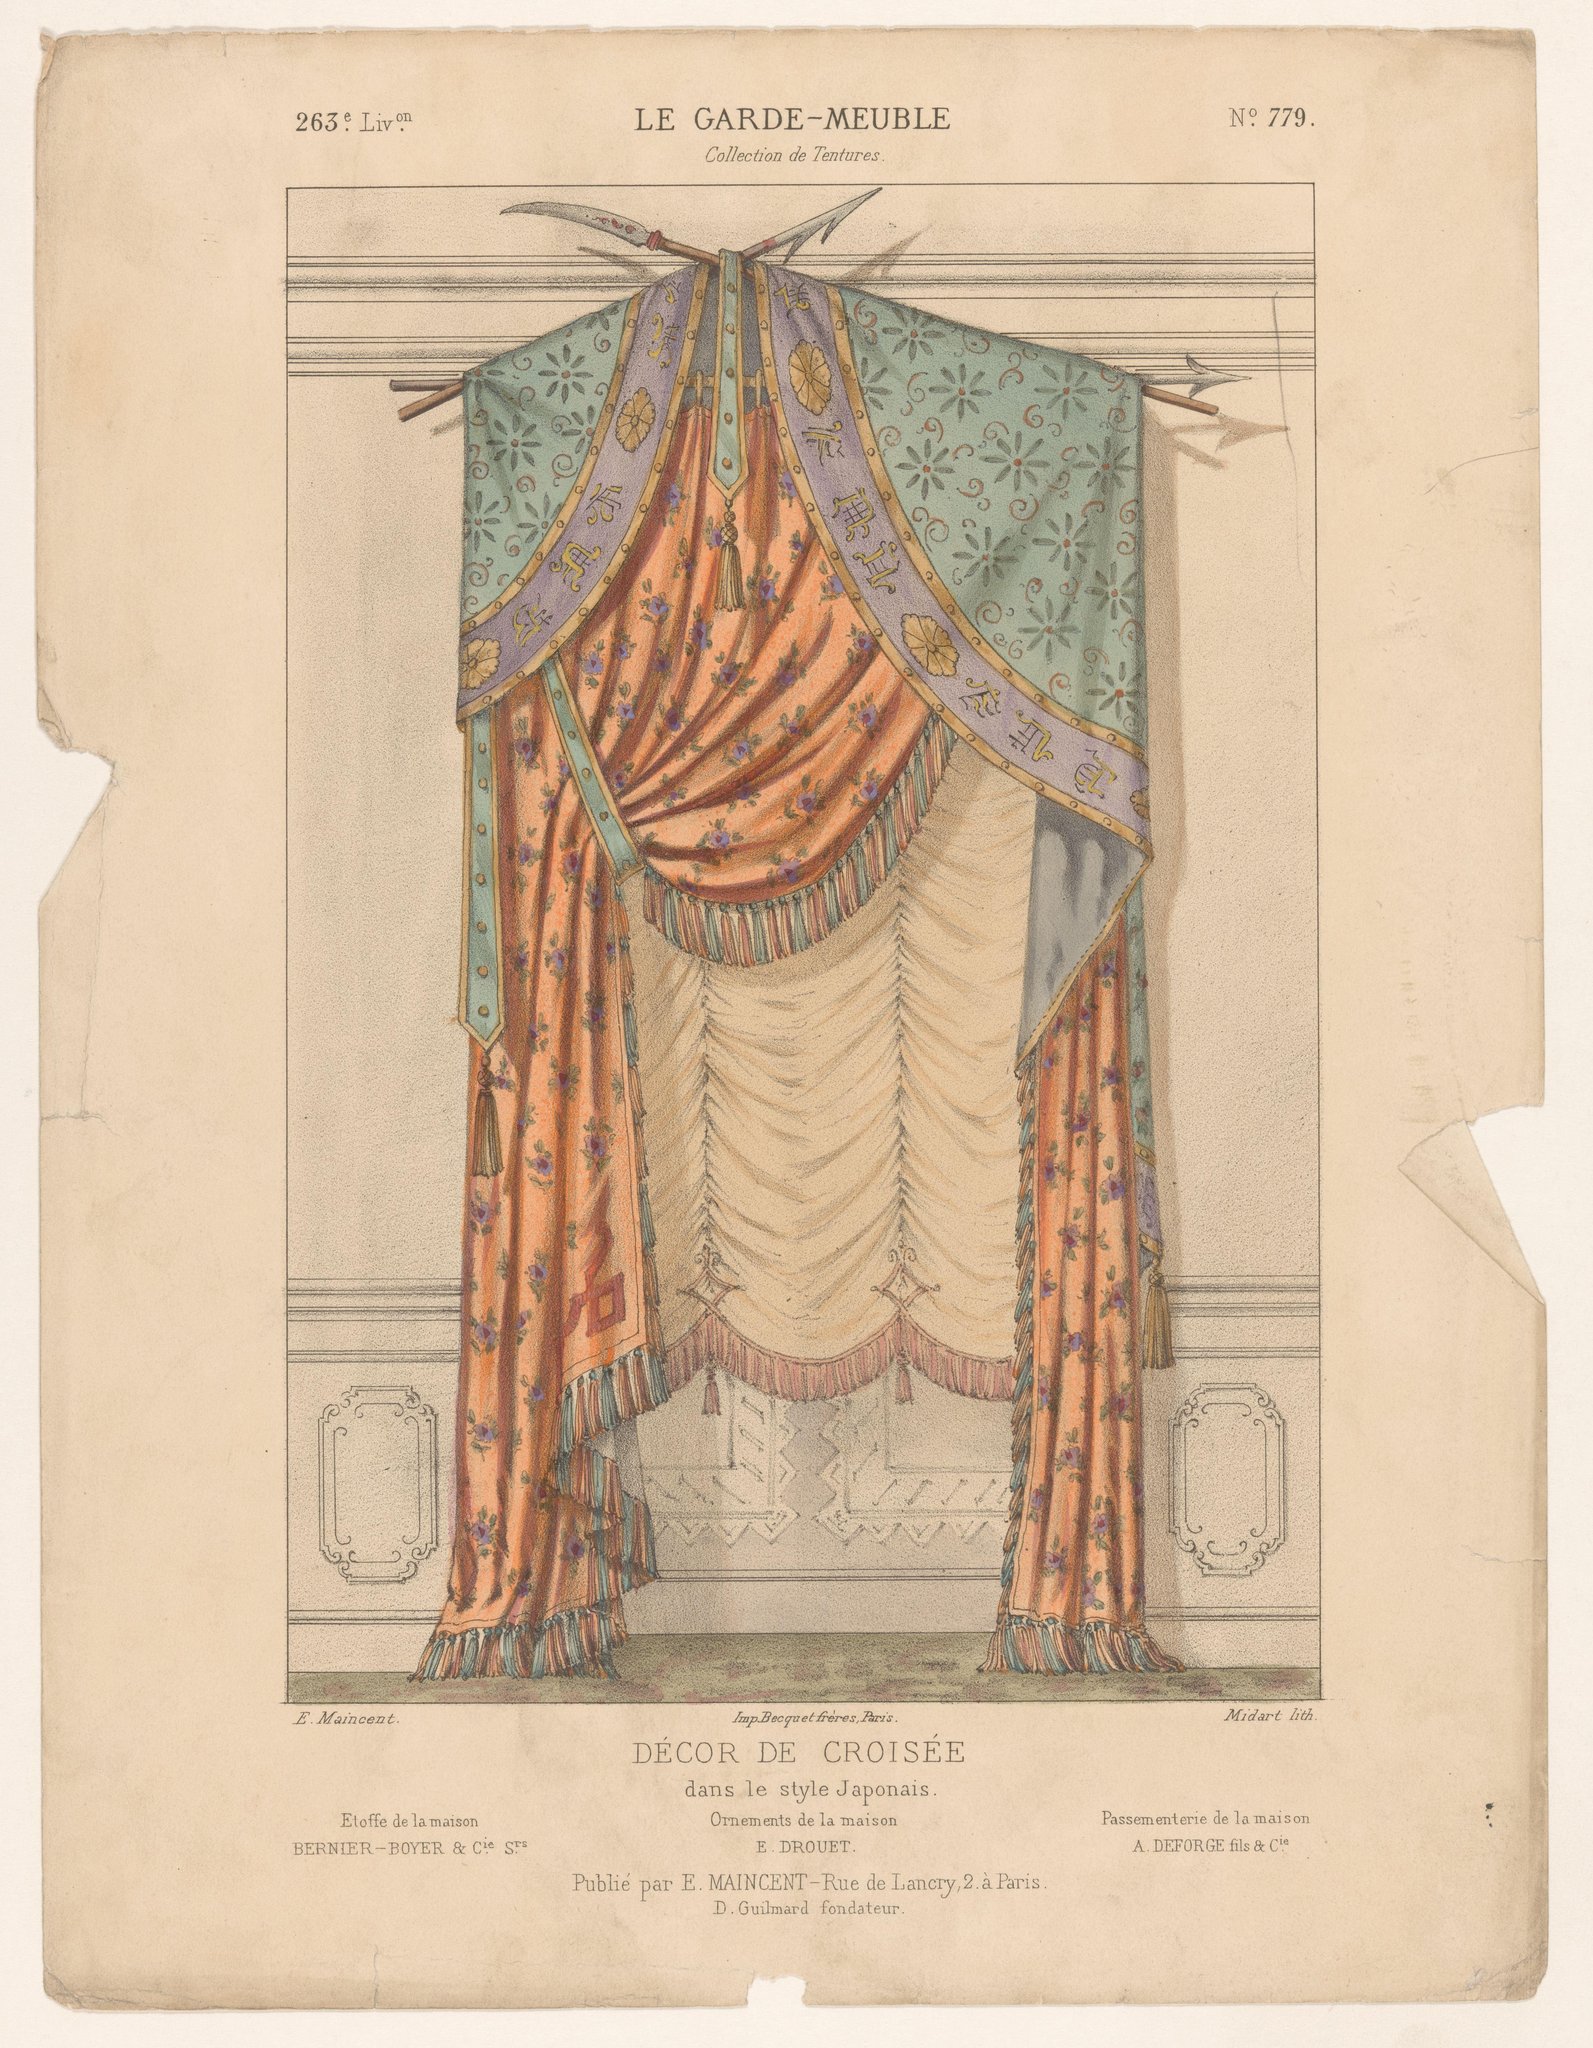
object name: print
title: Décor de Croisée dans le style Japonais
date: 1885-1895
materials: paper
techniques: hand coloring, lithograph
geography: paris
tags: window, hangings and drapery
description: Kruisvenster met gedrapeerde gordijnen in Japanse stijl. Prent uit 263e Livraison.